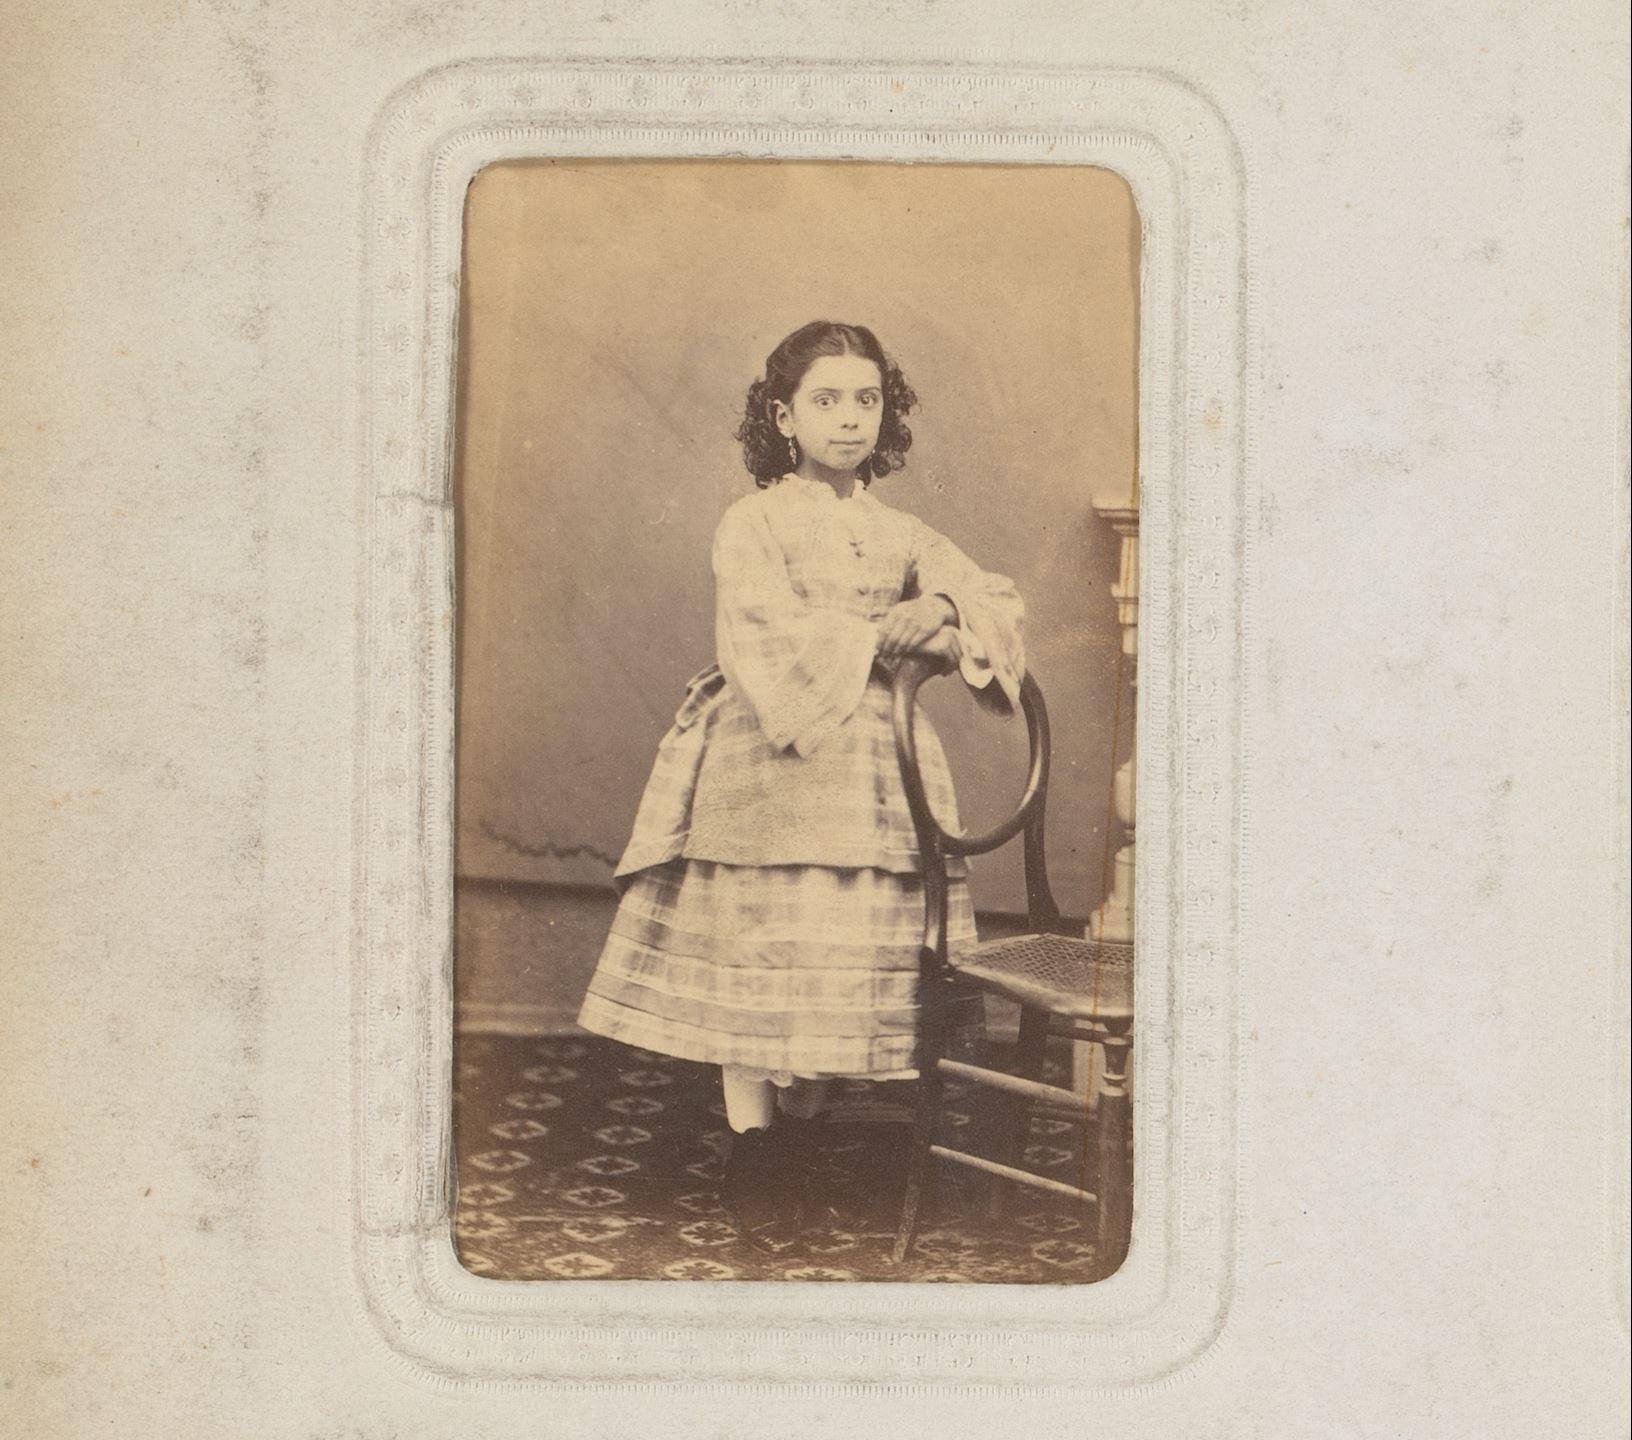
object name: album leaf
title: Portret van een meisje, staand bij een stoel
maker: r. buck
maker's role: fotograaf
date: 1860-1890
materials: cardboard, photographic support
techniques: albumen print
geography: vigo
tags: historical persons - bb - woman, girl (child between toddler and youth)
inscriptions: inscription: ‘R. Buck/ Vigo’